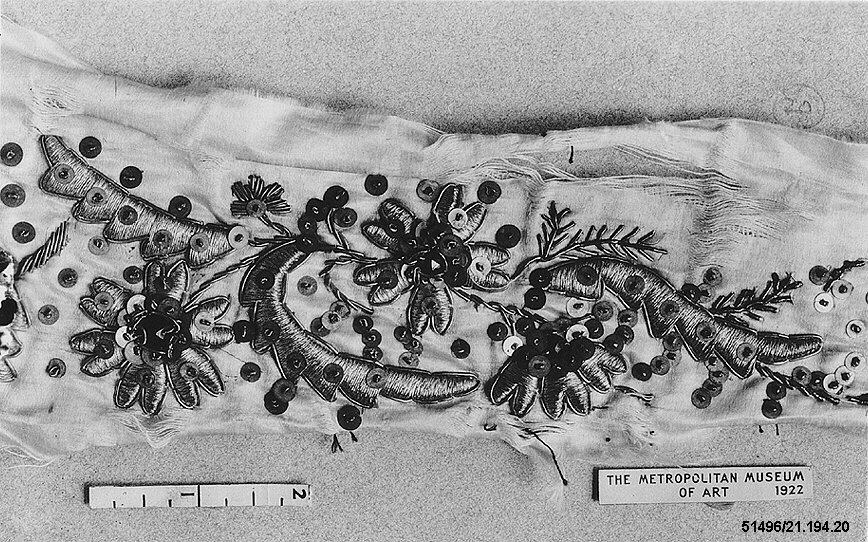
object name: fragment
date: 1801-1900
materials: metal thread, silk